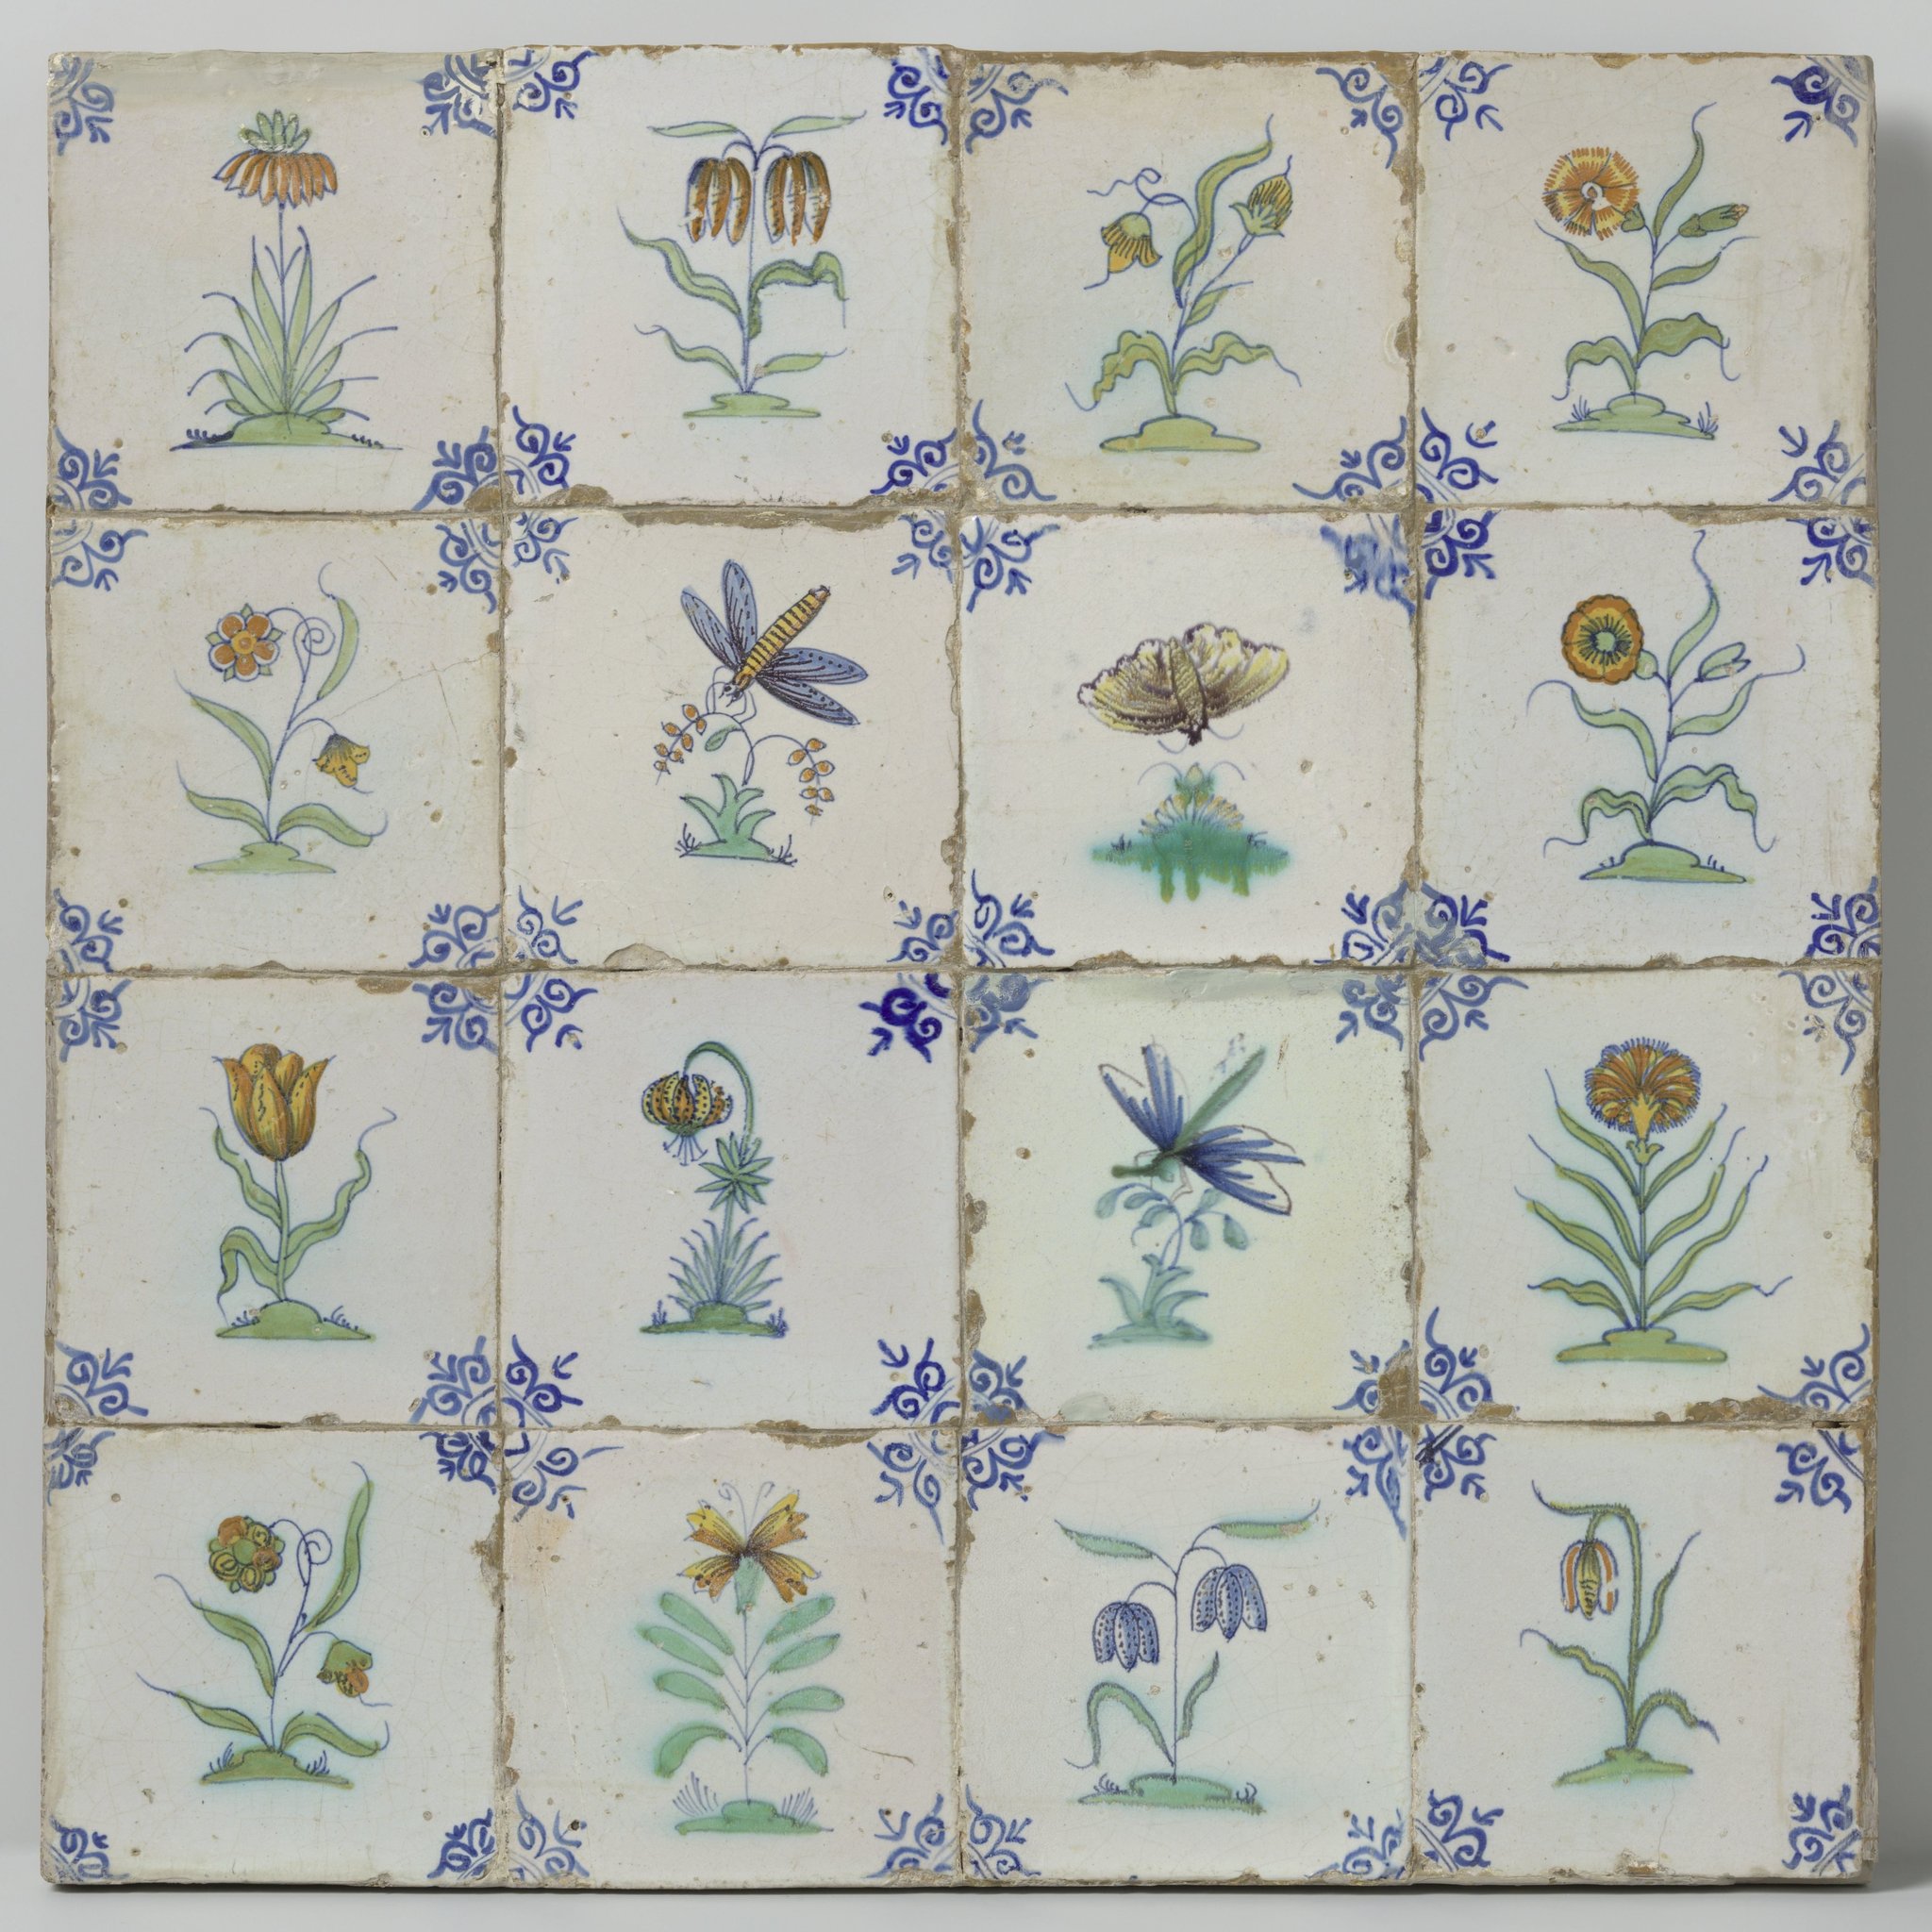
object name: tegelveld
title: Veld van zestien tegels met bloemen en insecten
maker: Anonymous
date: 1635-1670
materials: earthenware, glaze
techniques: maiolica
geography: netherlands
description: Veld van zestien tegels (4 x 4) met een veelkleurige (blauw, groen, geel, oranje en paars) insect of bloem op een grond. In de hoeken, een ossenkop.